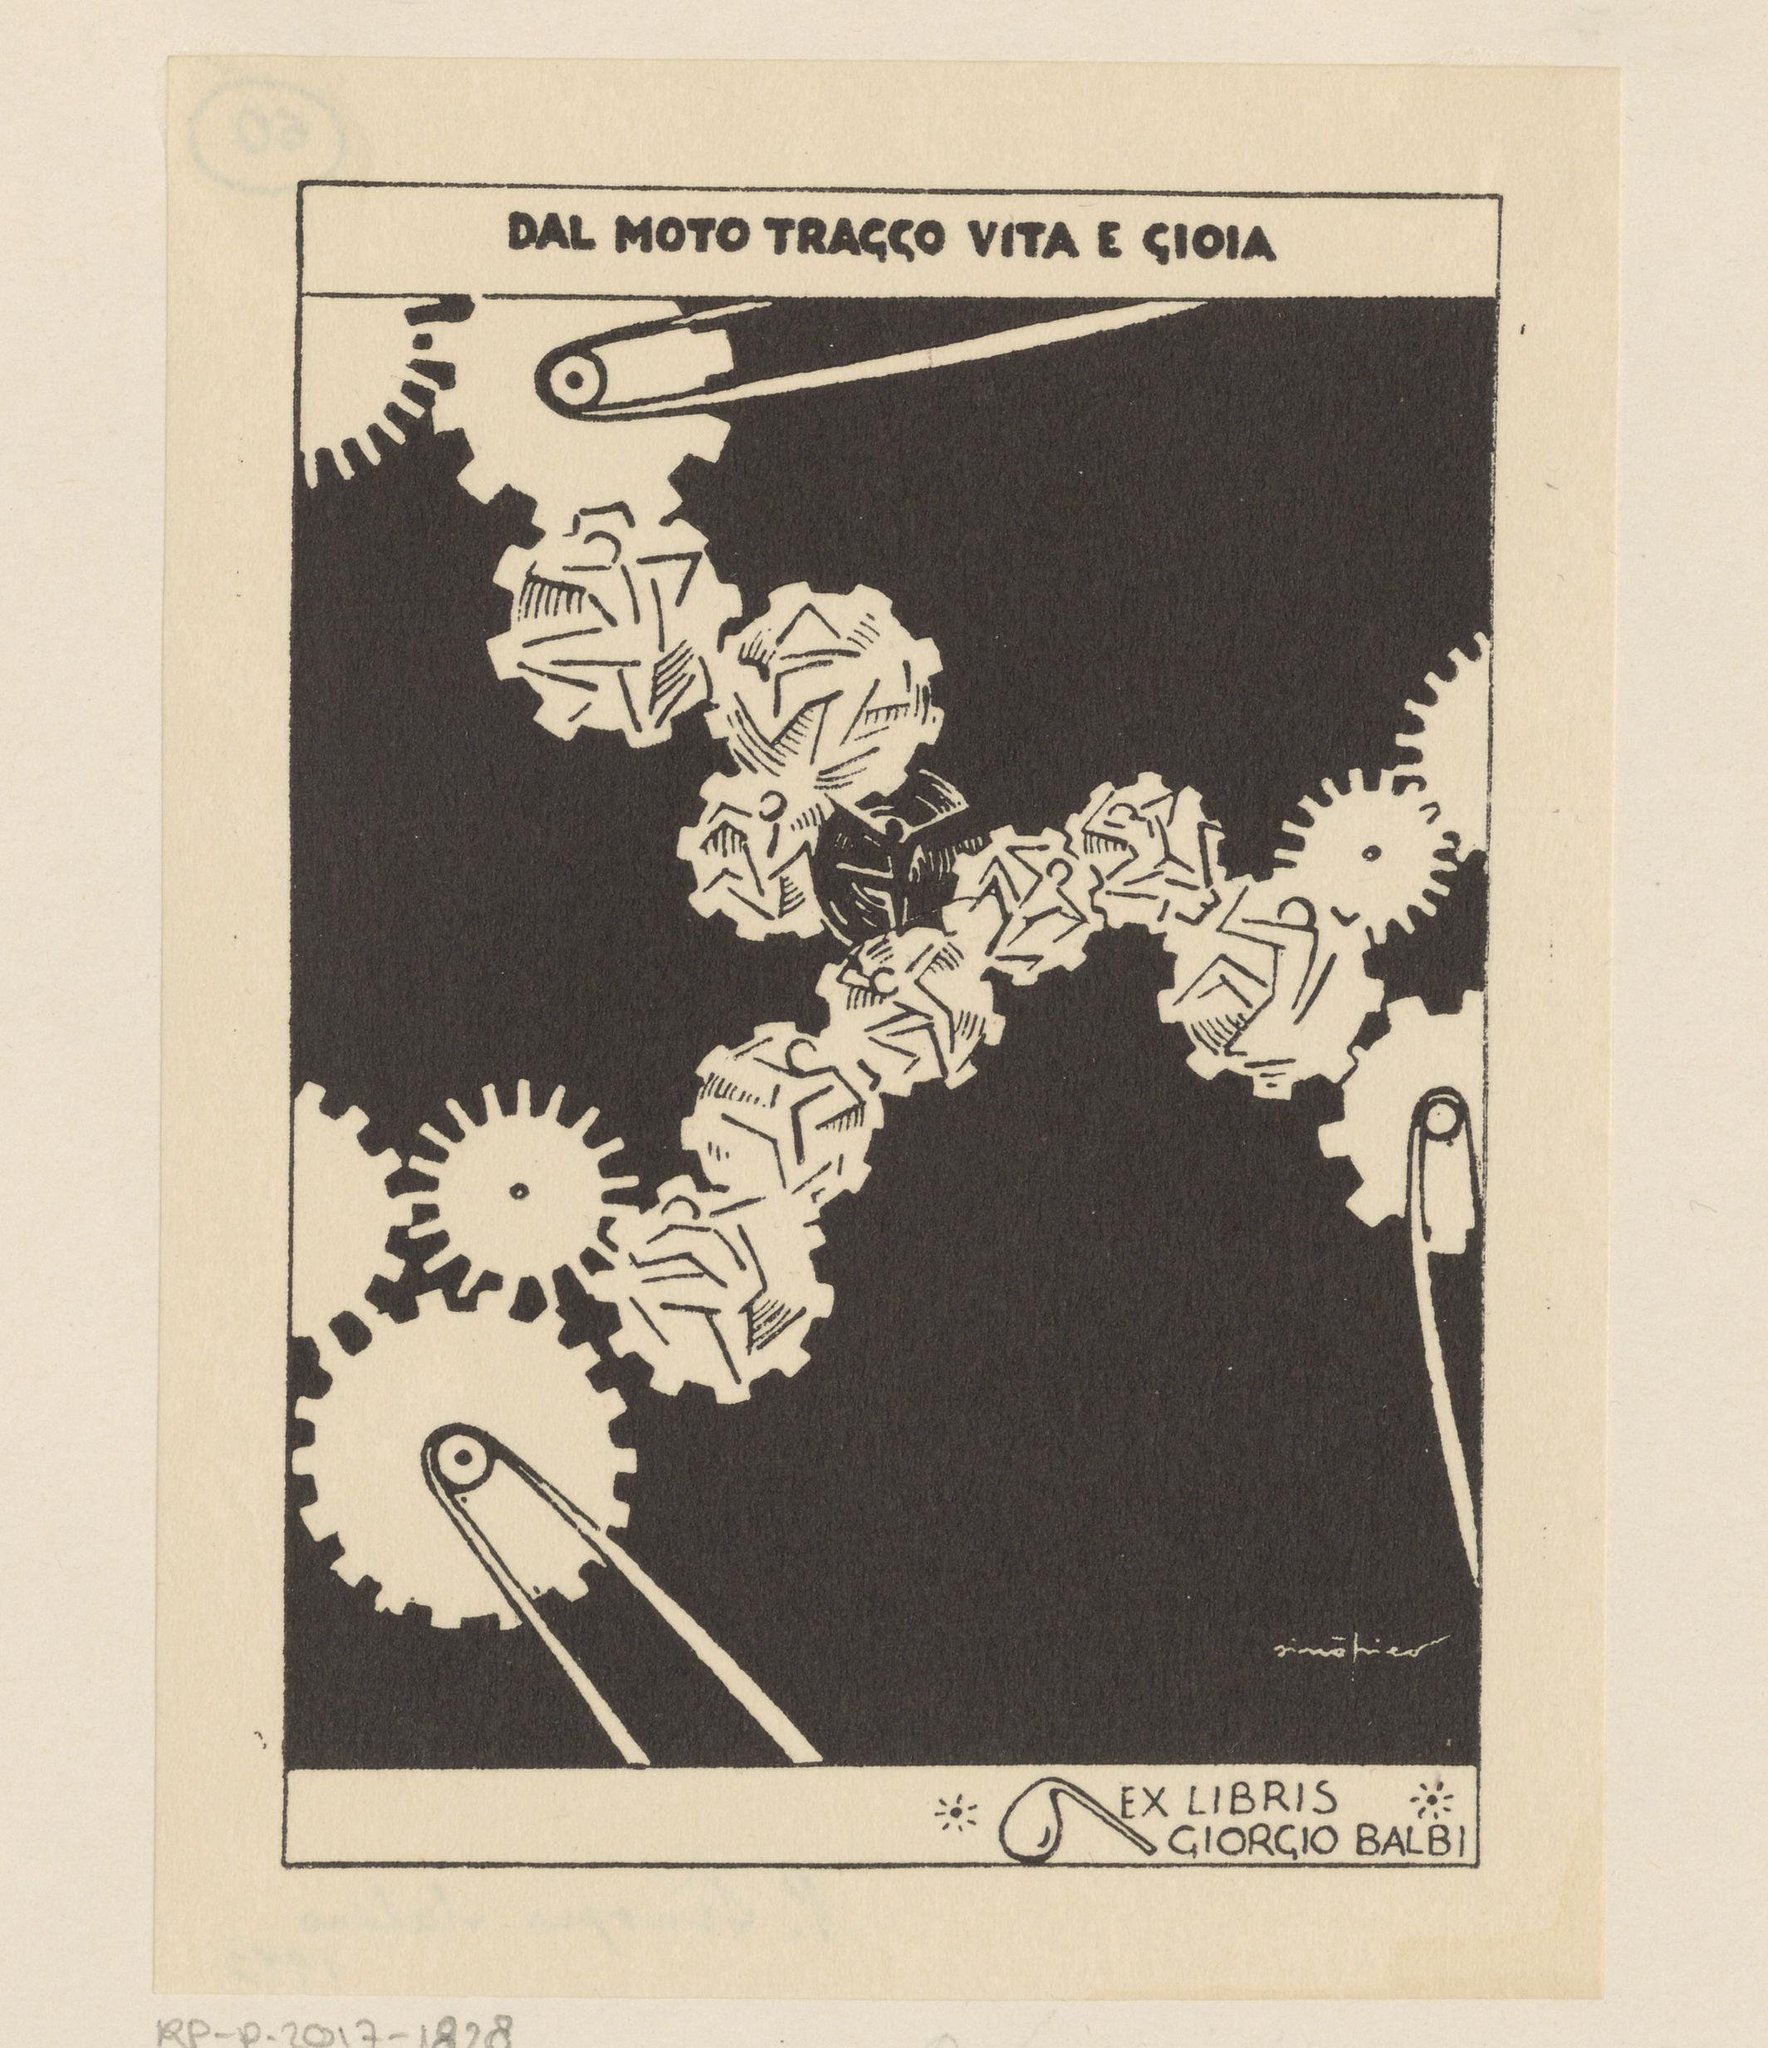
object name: bookplate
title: Ex libris van Giorgio Balbi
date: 1943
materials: paper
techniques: printing block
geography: italy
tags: mechanics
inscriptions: inscription: ‘P. Sinopio Milano 1943’